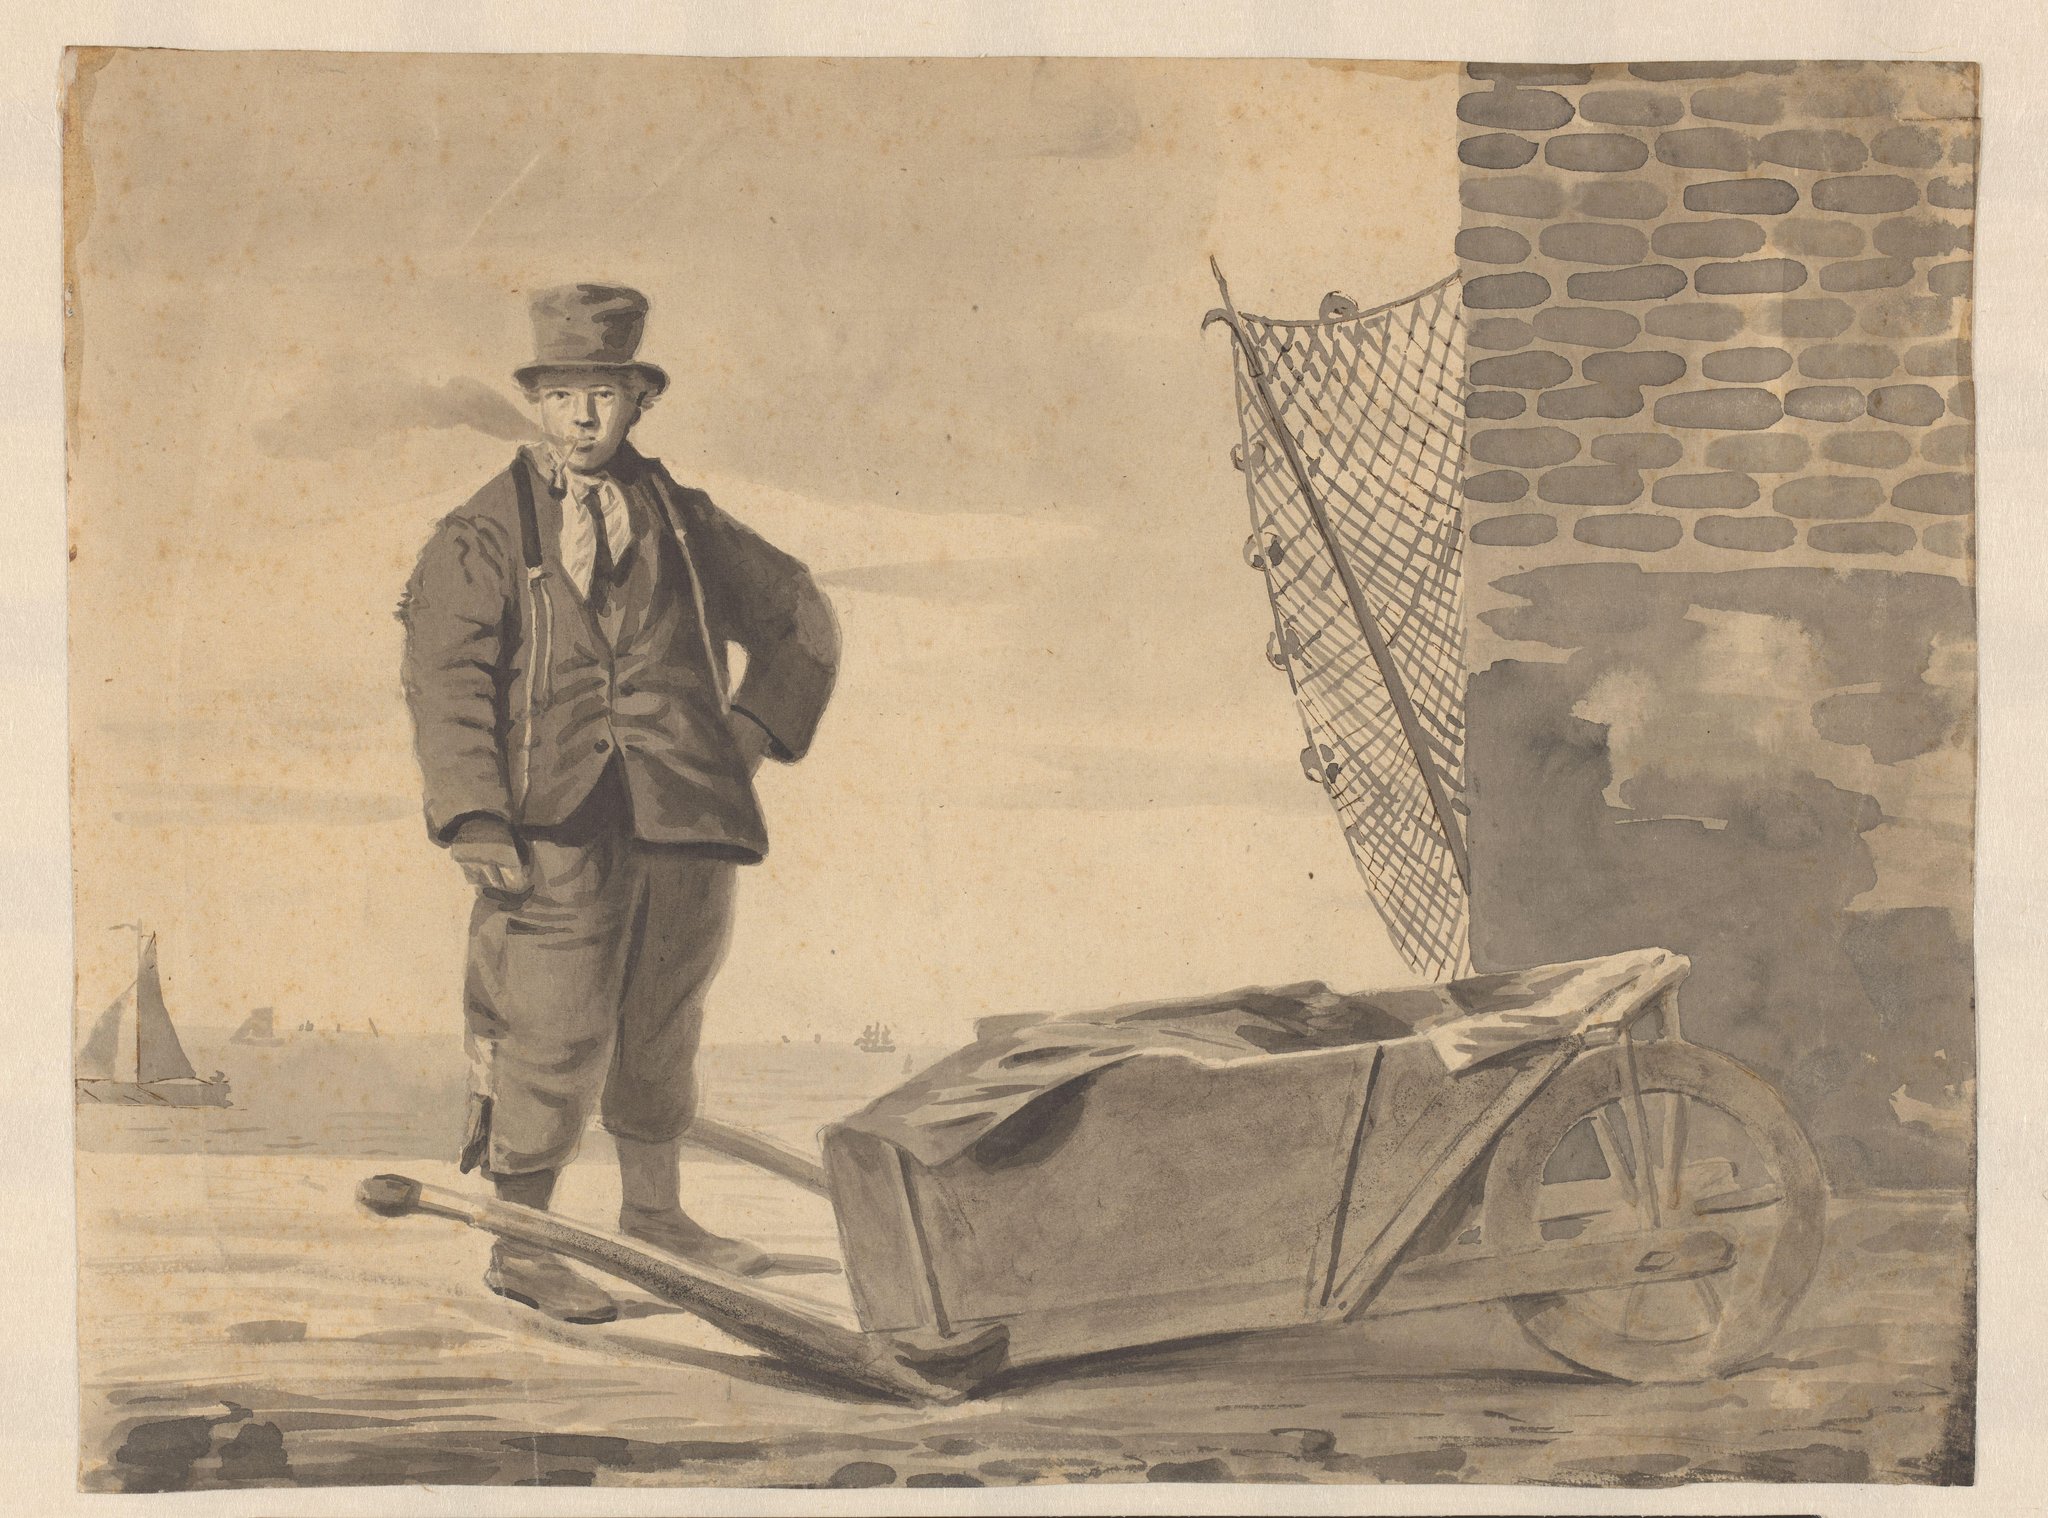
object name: drawing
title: Rokende visser met kruiwagen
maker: l.f.h. andrau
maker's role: draughtsman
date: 1864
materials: chalk, ink, paper, pencil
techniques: brush, pen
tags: wheelbarrow, fisherman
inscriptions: date: ‘1864 19 Jan’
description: Achter de man zijn zeilschepen op het water te zien.